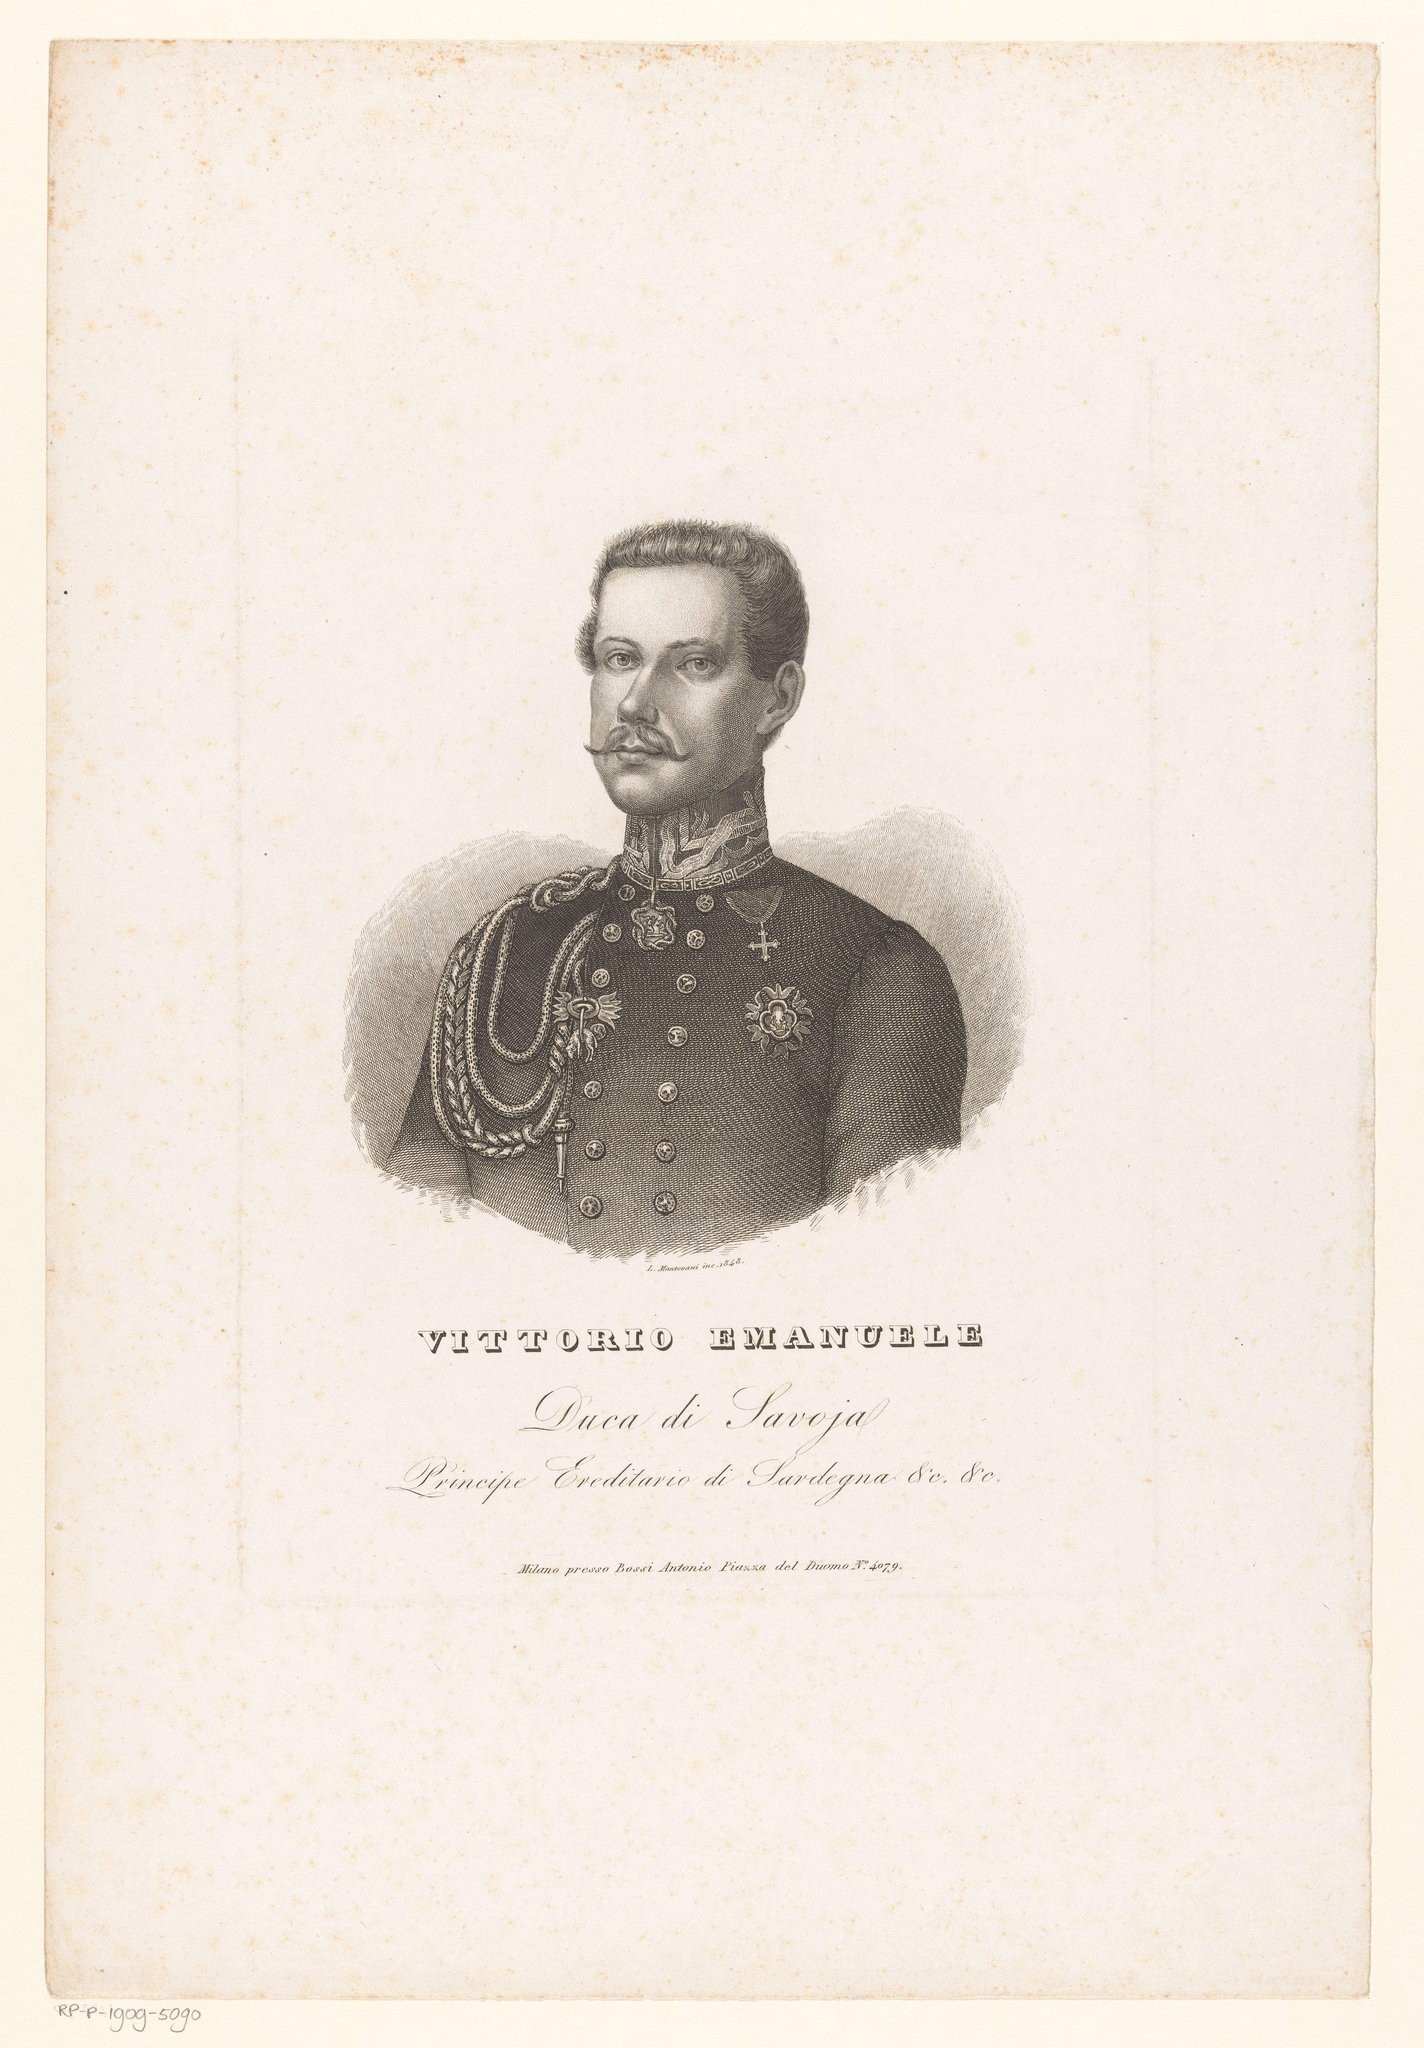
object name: print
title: Portret van Vittorio Emanuele II, koning van Italië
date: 1848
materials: paper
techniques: engraving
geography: milan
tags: rome, historical persons, ruler, sovereign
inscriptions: collector's mark